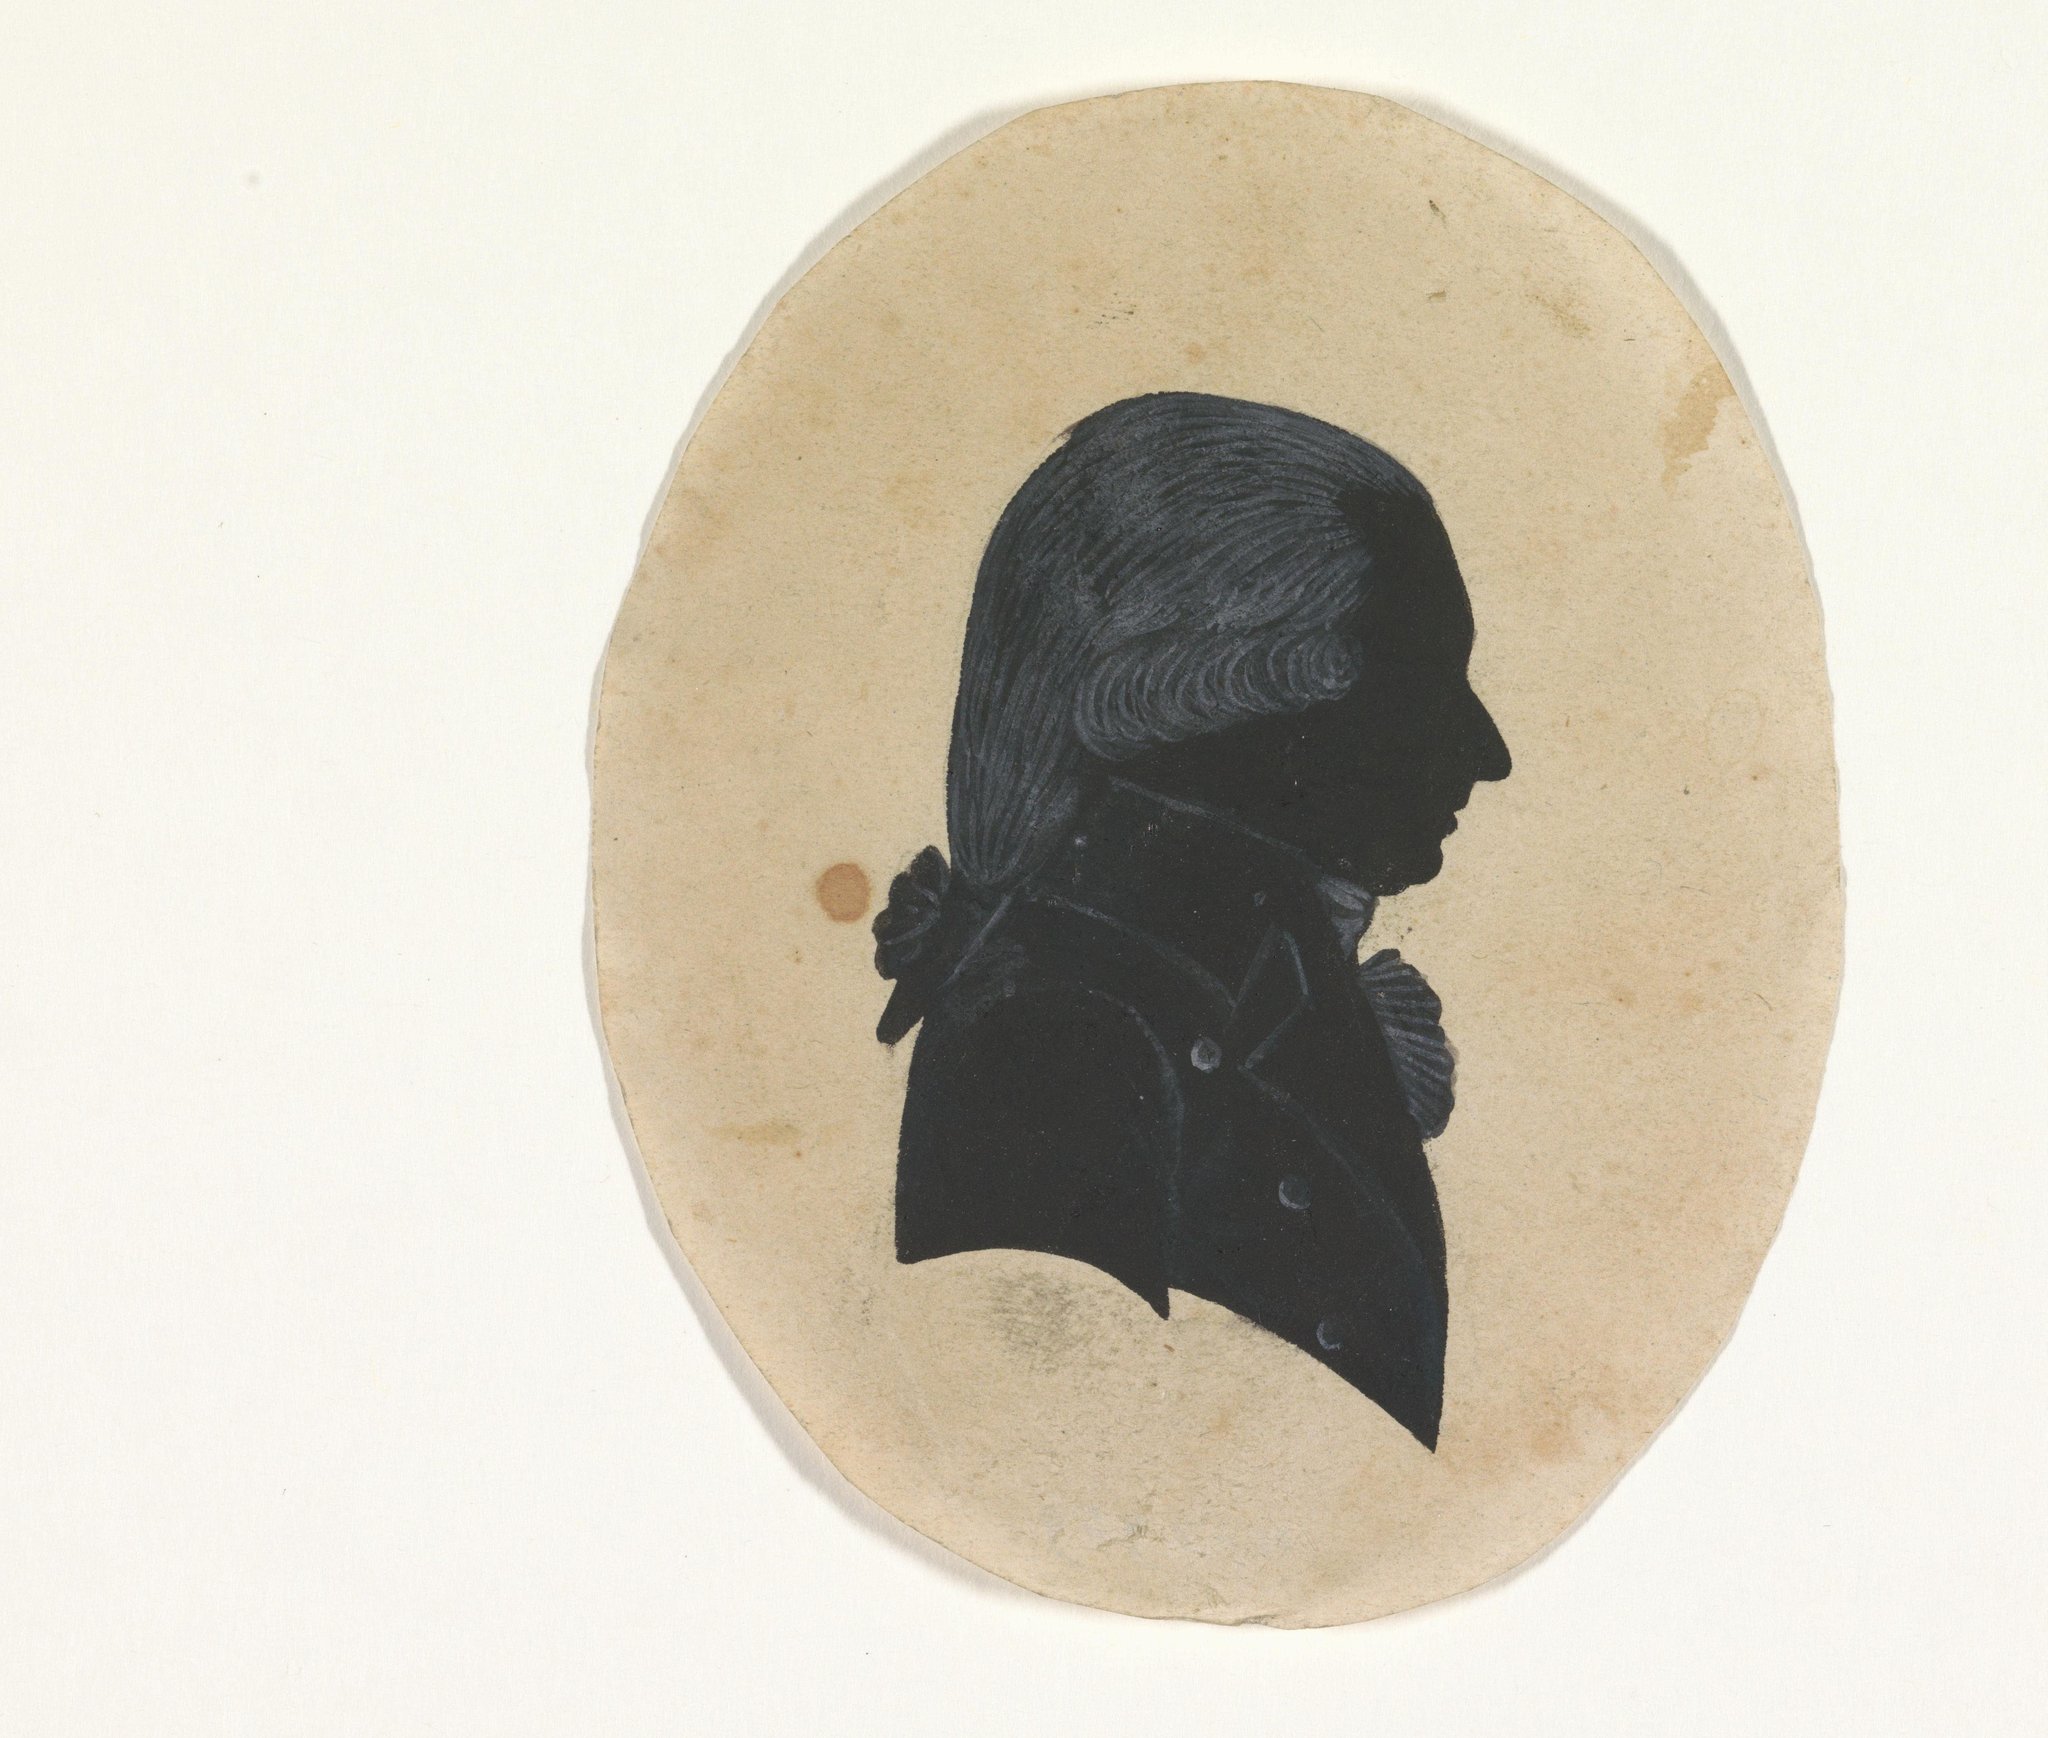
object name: drawing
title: Silhouet van een man naar rechts kijkend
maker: Anonymous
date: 1700-1900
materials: paper, pencil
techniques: brush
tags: historical persons, male sex; man